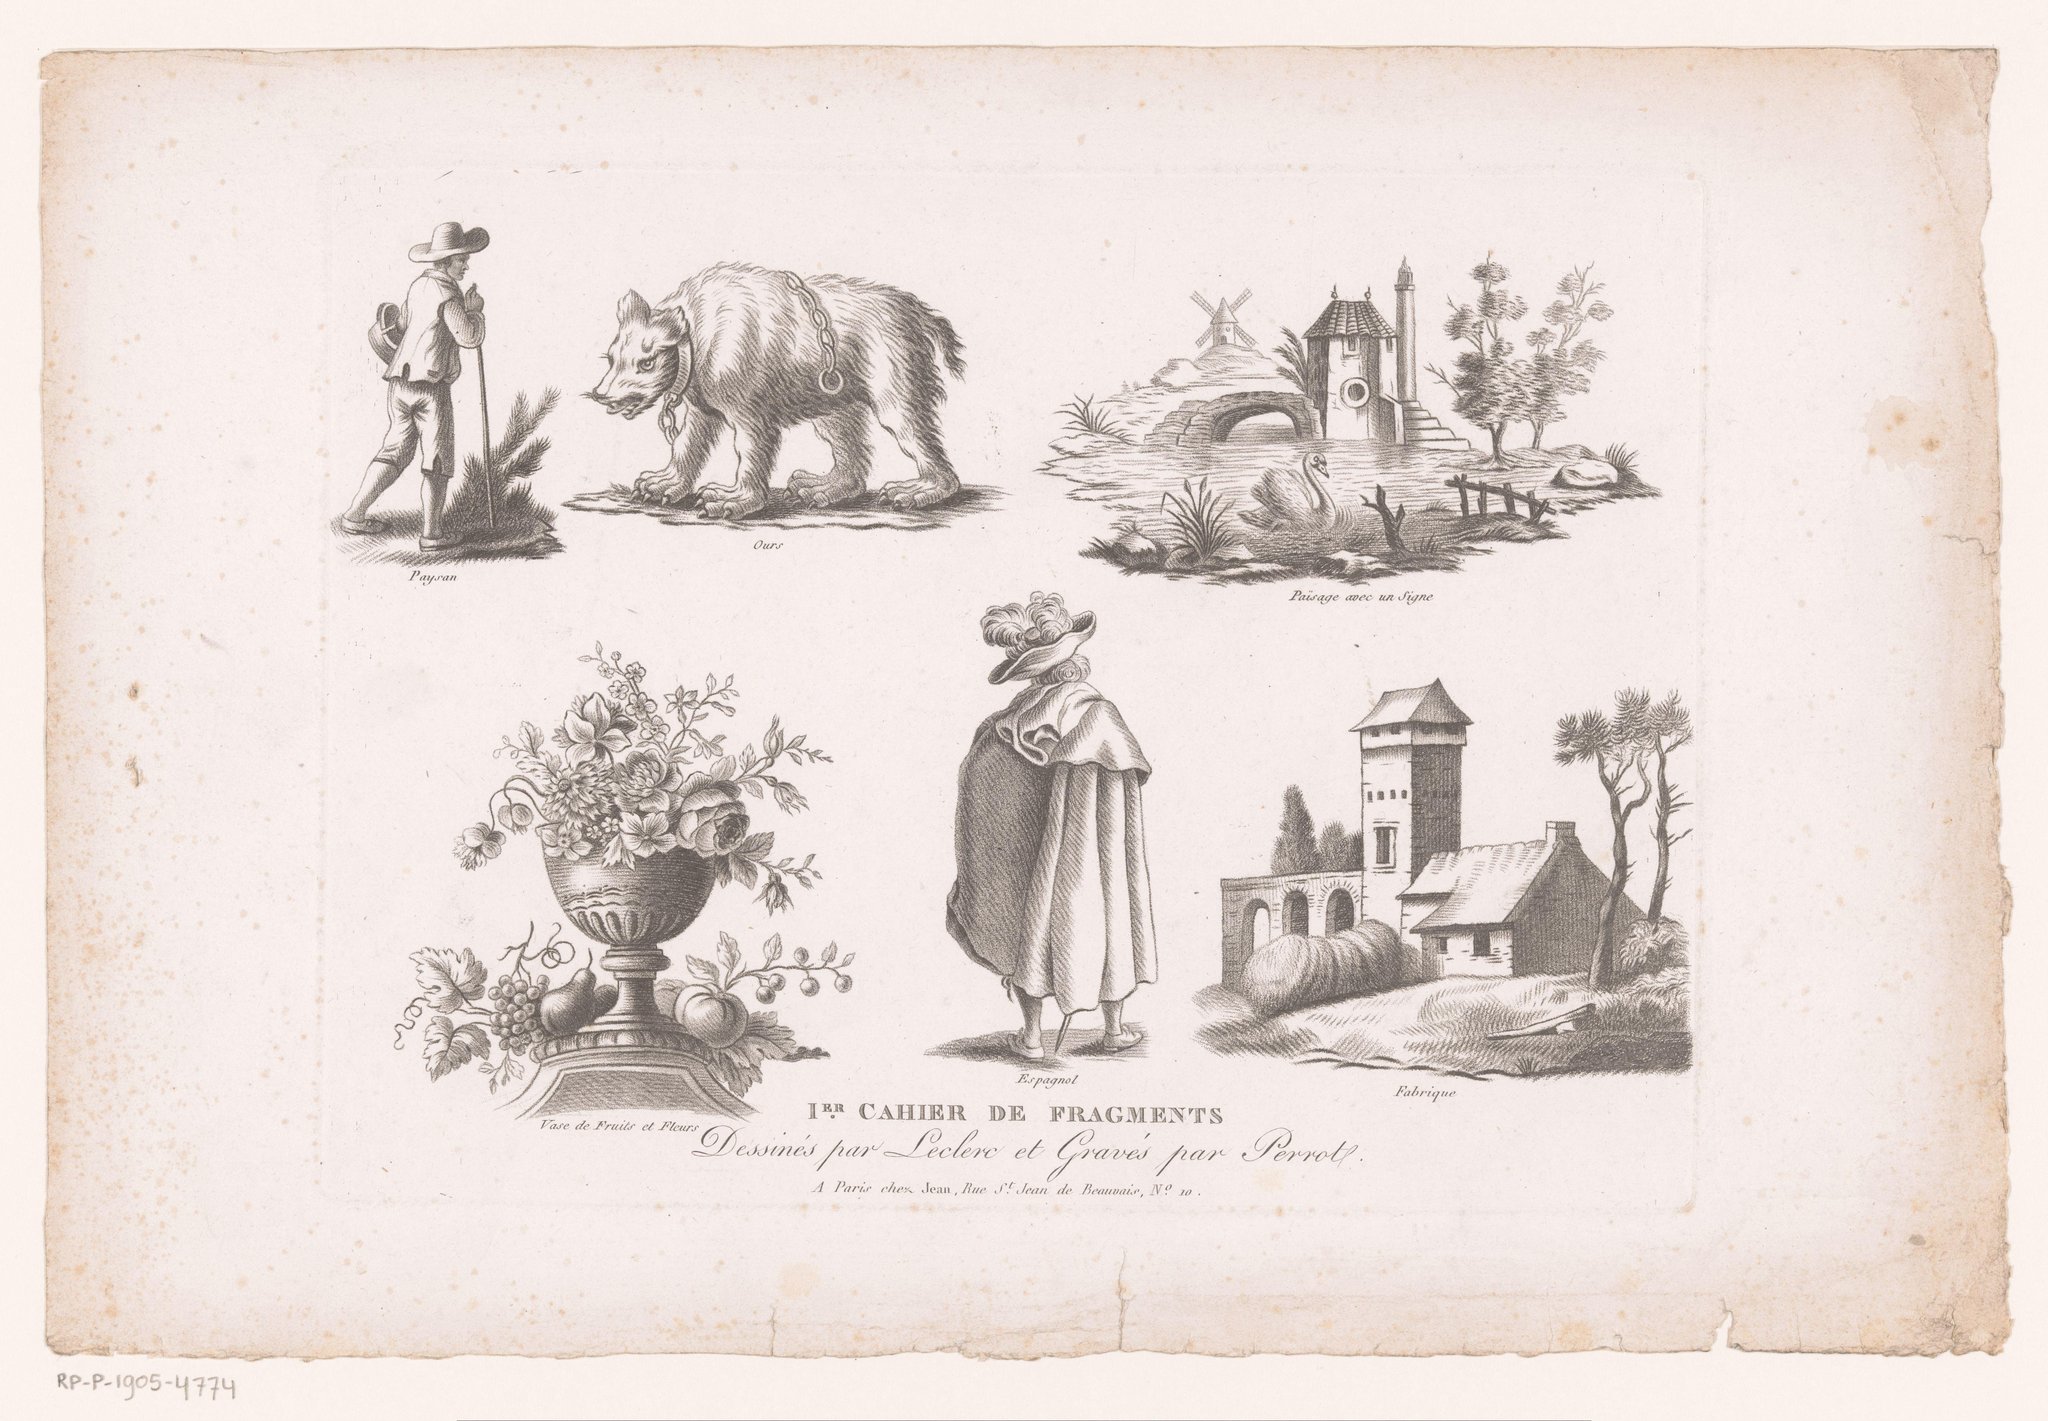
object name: print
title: Fragmenten om de jeugd mee te amuseren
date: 1784-1796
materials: paper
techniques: printmaking, etching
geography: paris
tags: landscapes, farmers, beasts of prey, predatory animals: bear, still life of plants, flowers and fruit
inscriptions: collector's mark: Lugt 2228